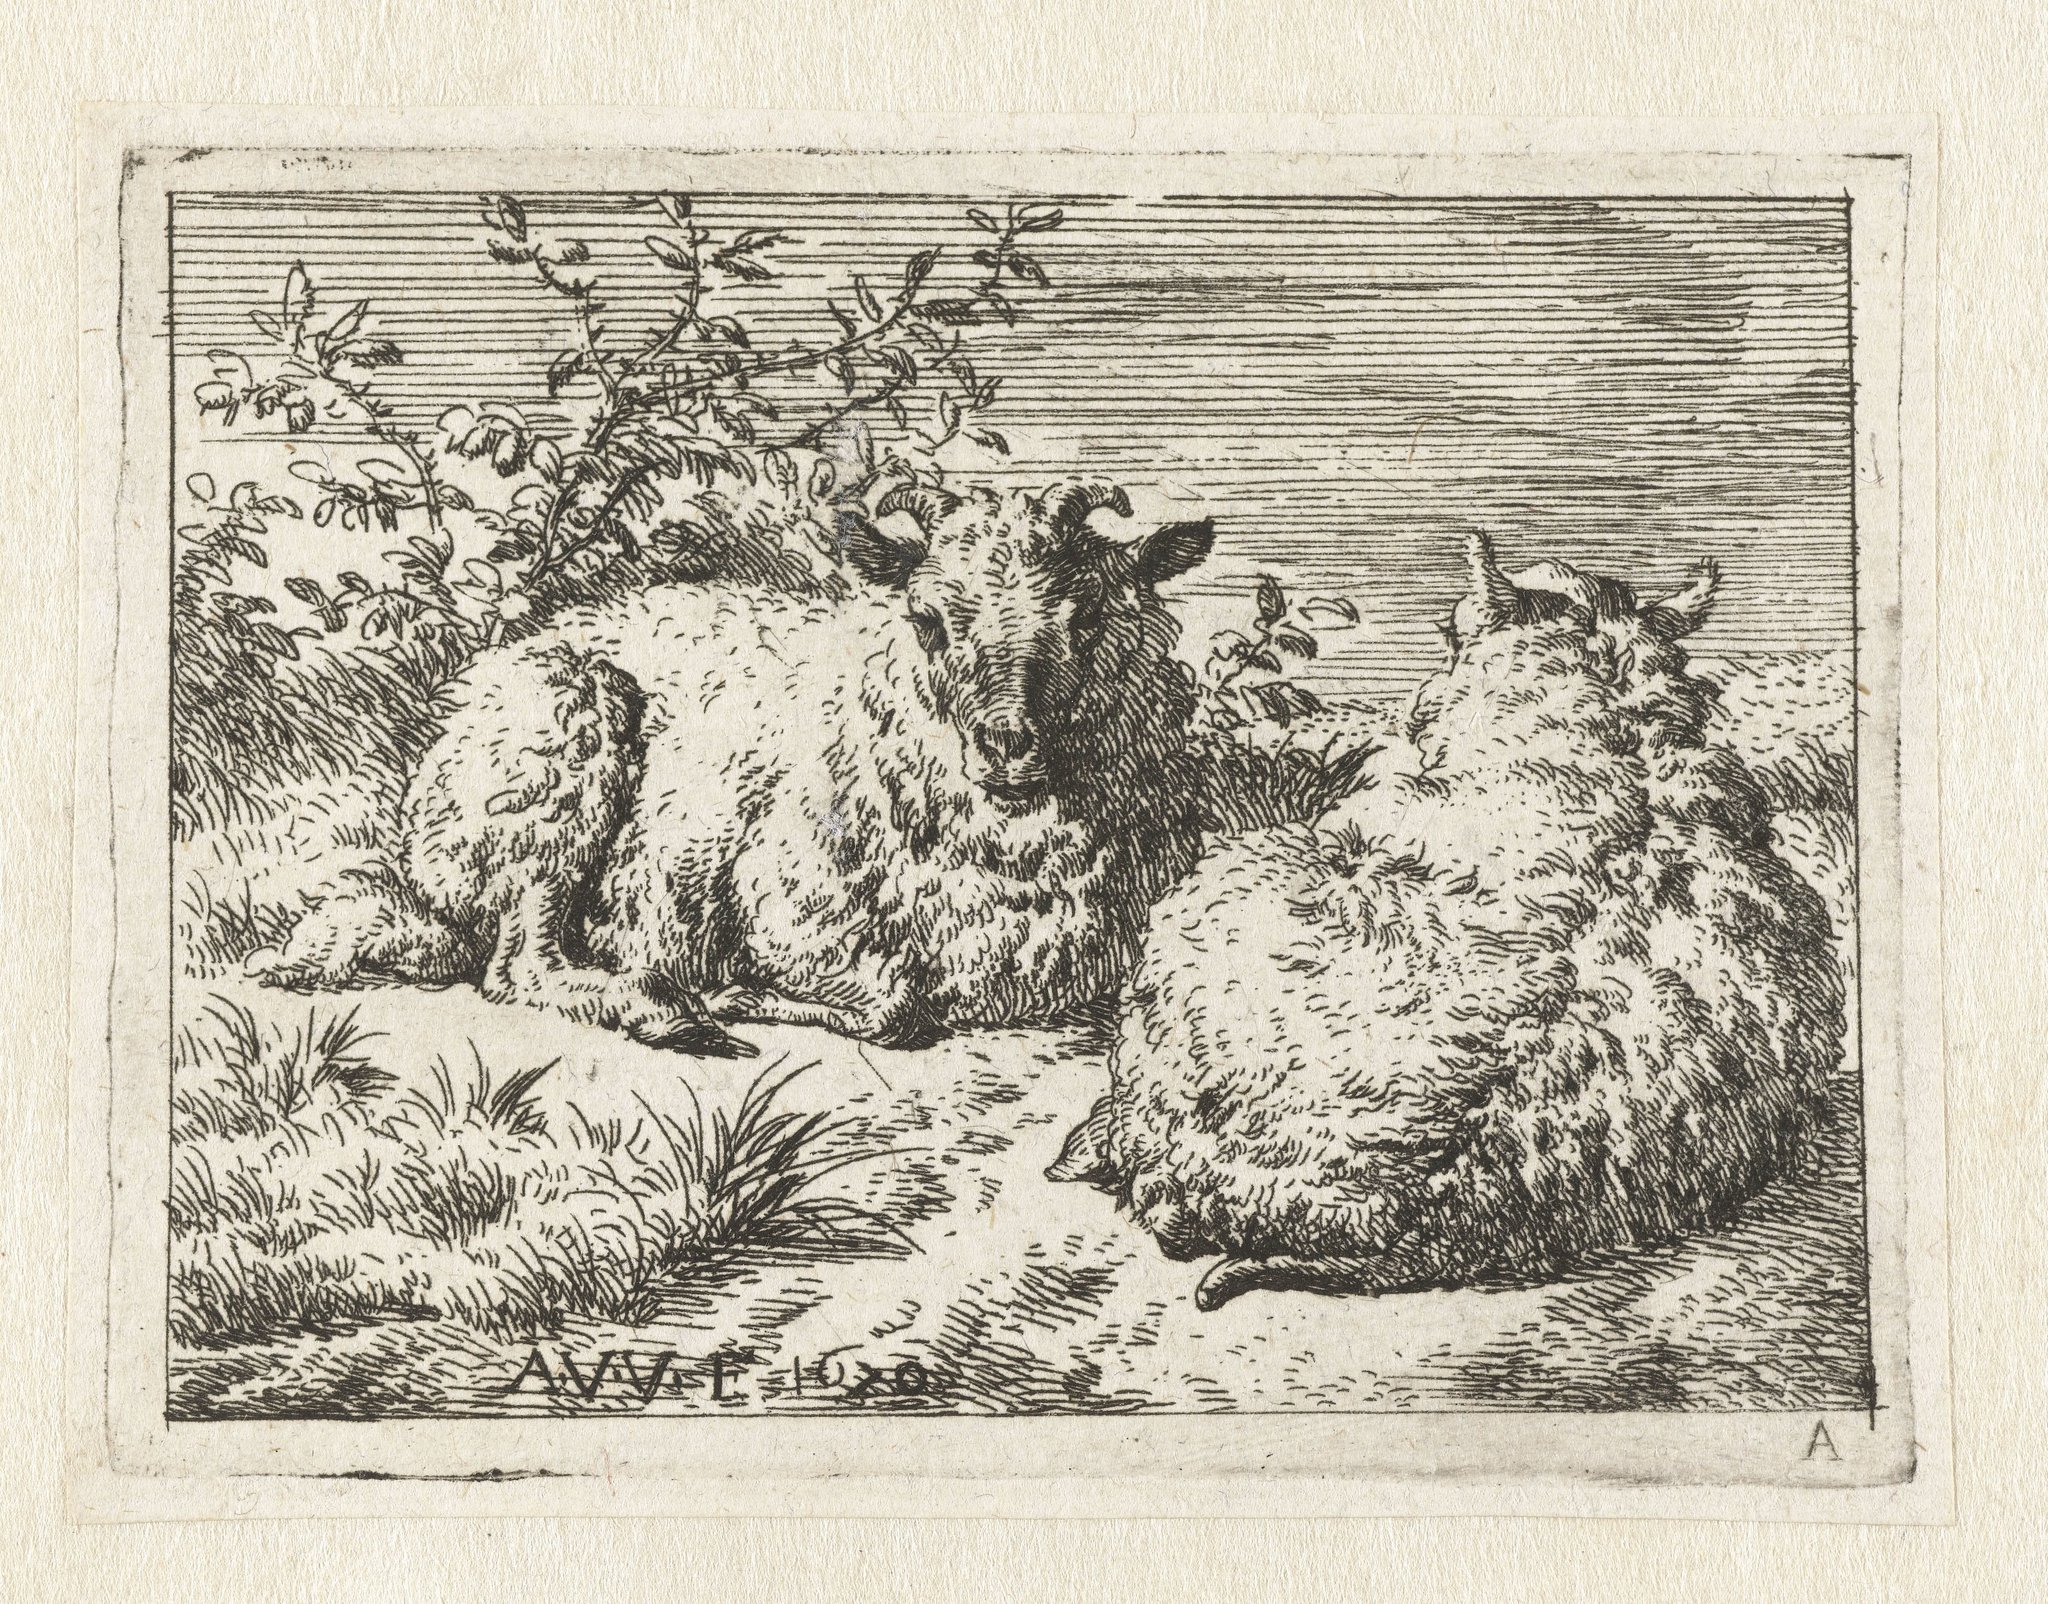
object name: print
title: Schapen en geiten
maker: adriaen van de velde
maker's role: draughtsman, painter, print maker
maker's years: 1636-1672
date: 1670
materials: paper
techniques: etching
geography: amsterdam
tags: sheep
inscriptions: collector's mark: Lugt 240